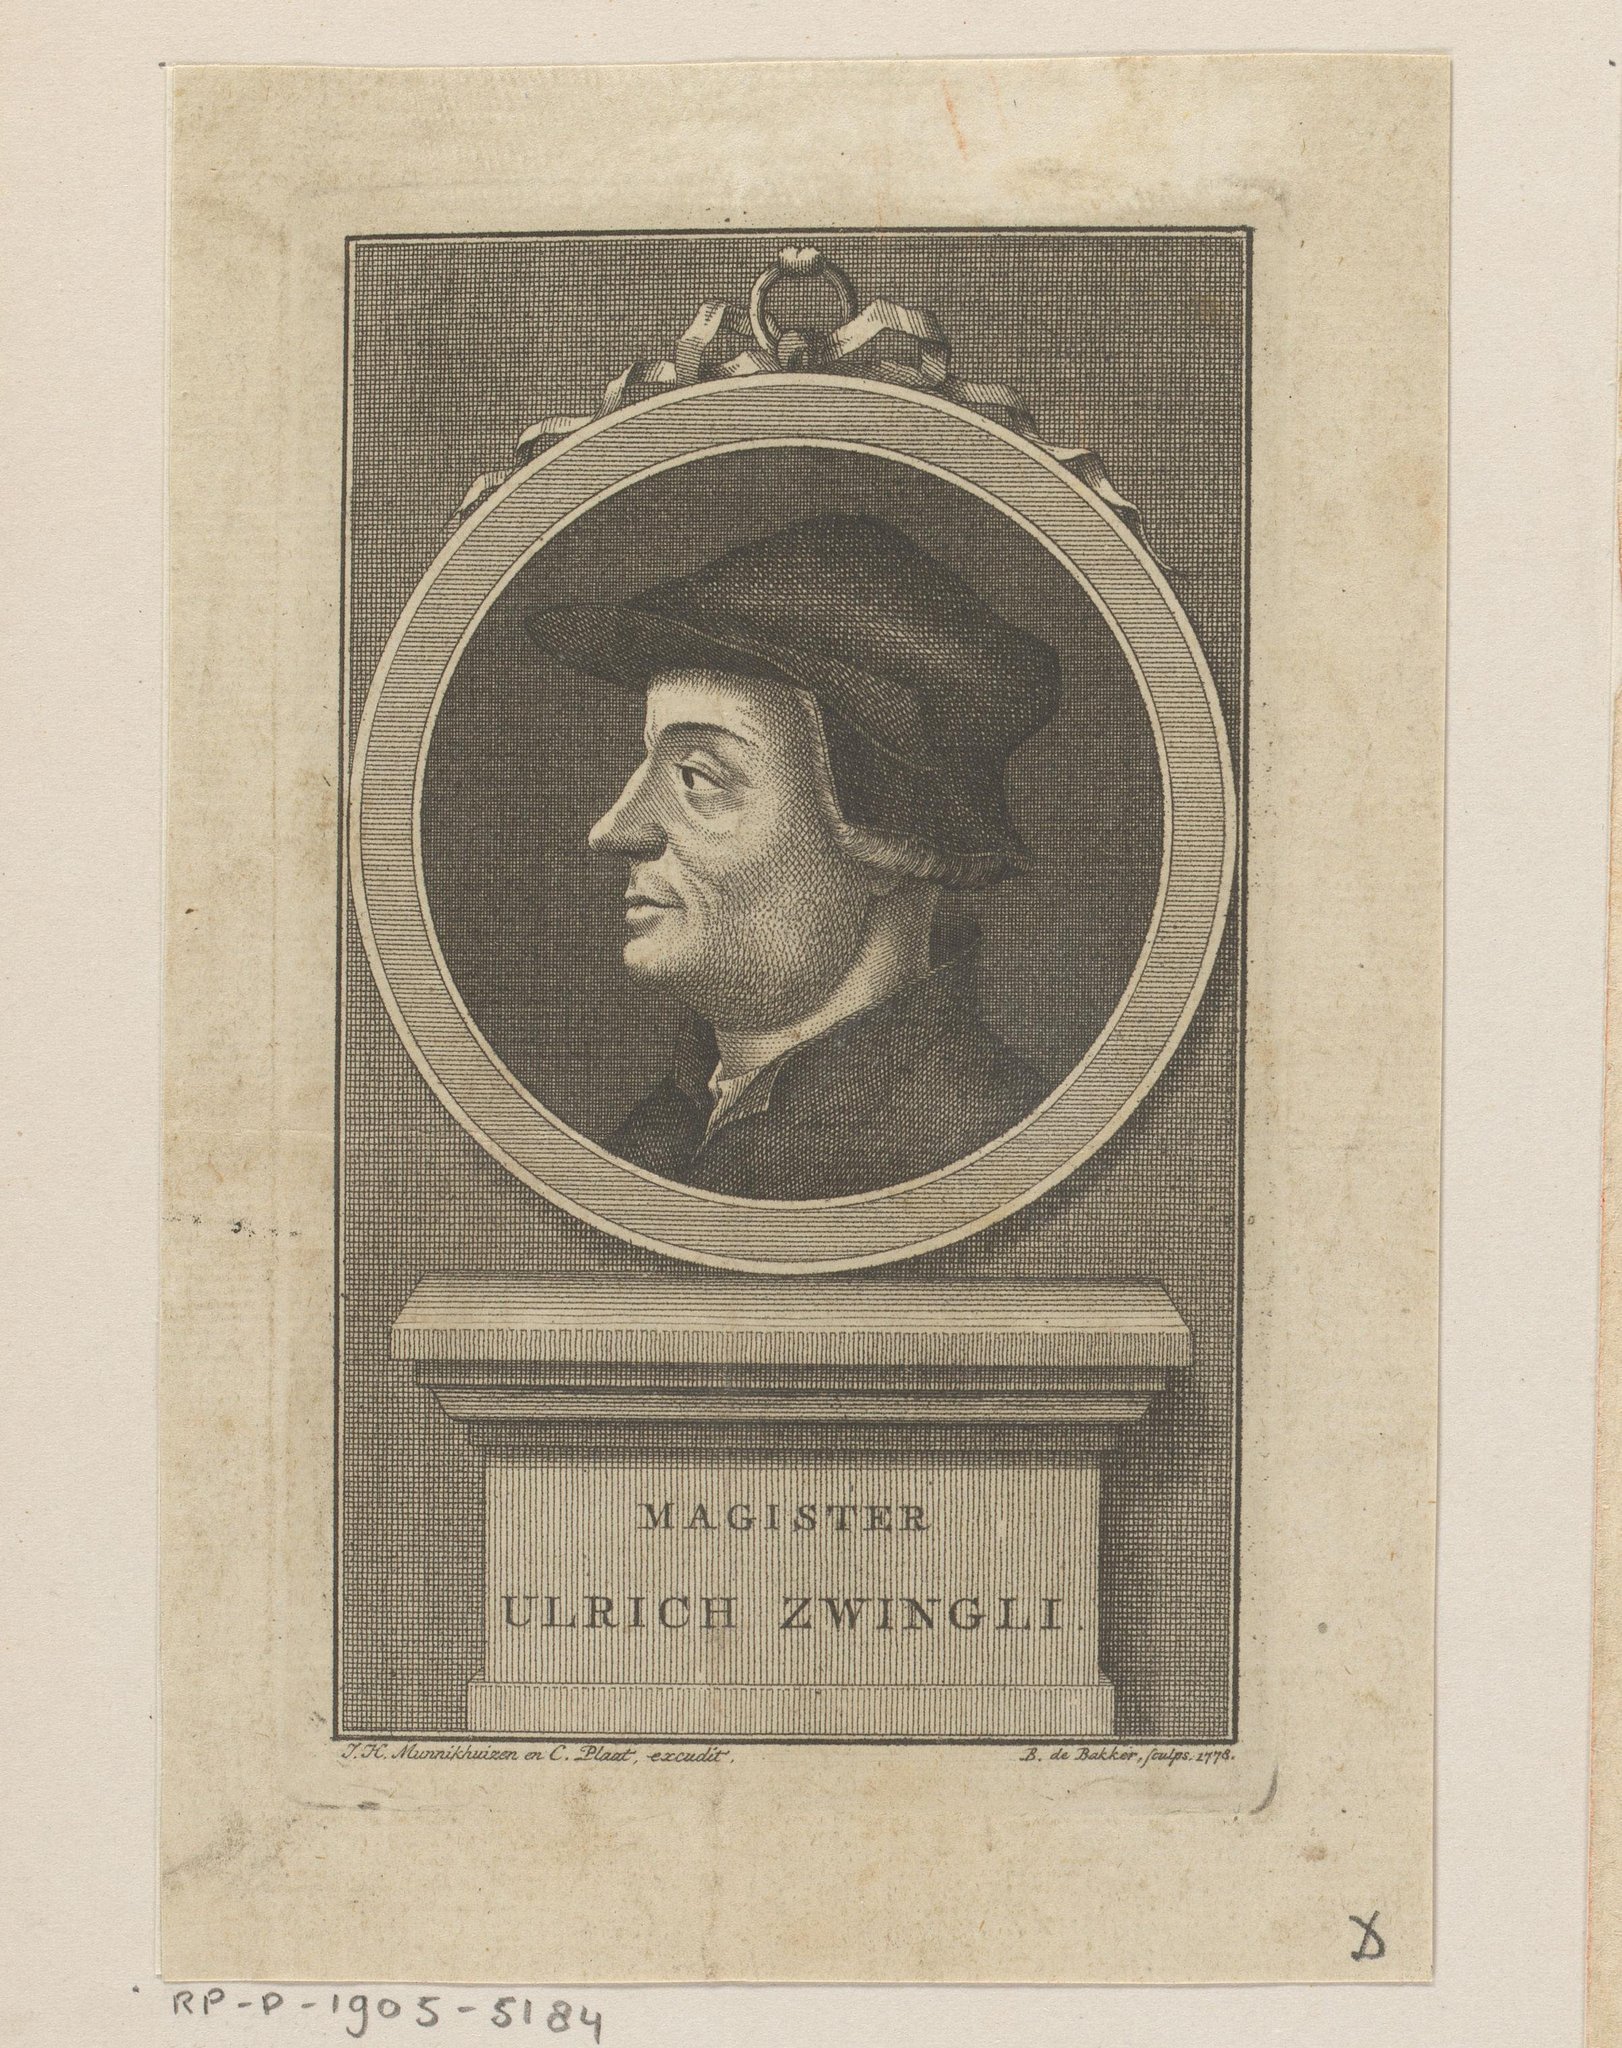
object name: print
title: Magister Ulrich Zwingli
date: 1778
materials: paper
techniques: etching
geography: the hague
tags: clergyman, theologian, historical persons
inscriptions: collector's mark: Lugt 2228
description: Prent uit: Nüscheler, Felix. Het leven van magister Ulrich Zwingli. Den Haag: Jan Hendrik Munnikhuizen en Christiaan Plaat, 1778.